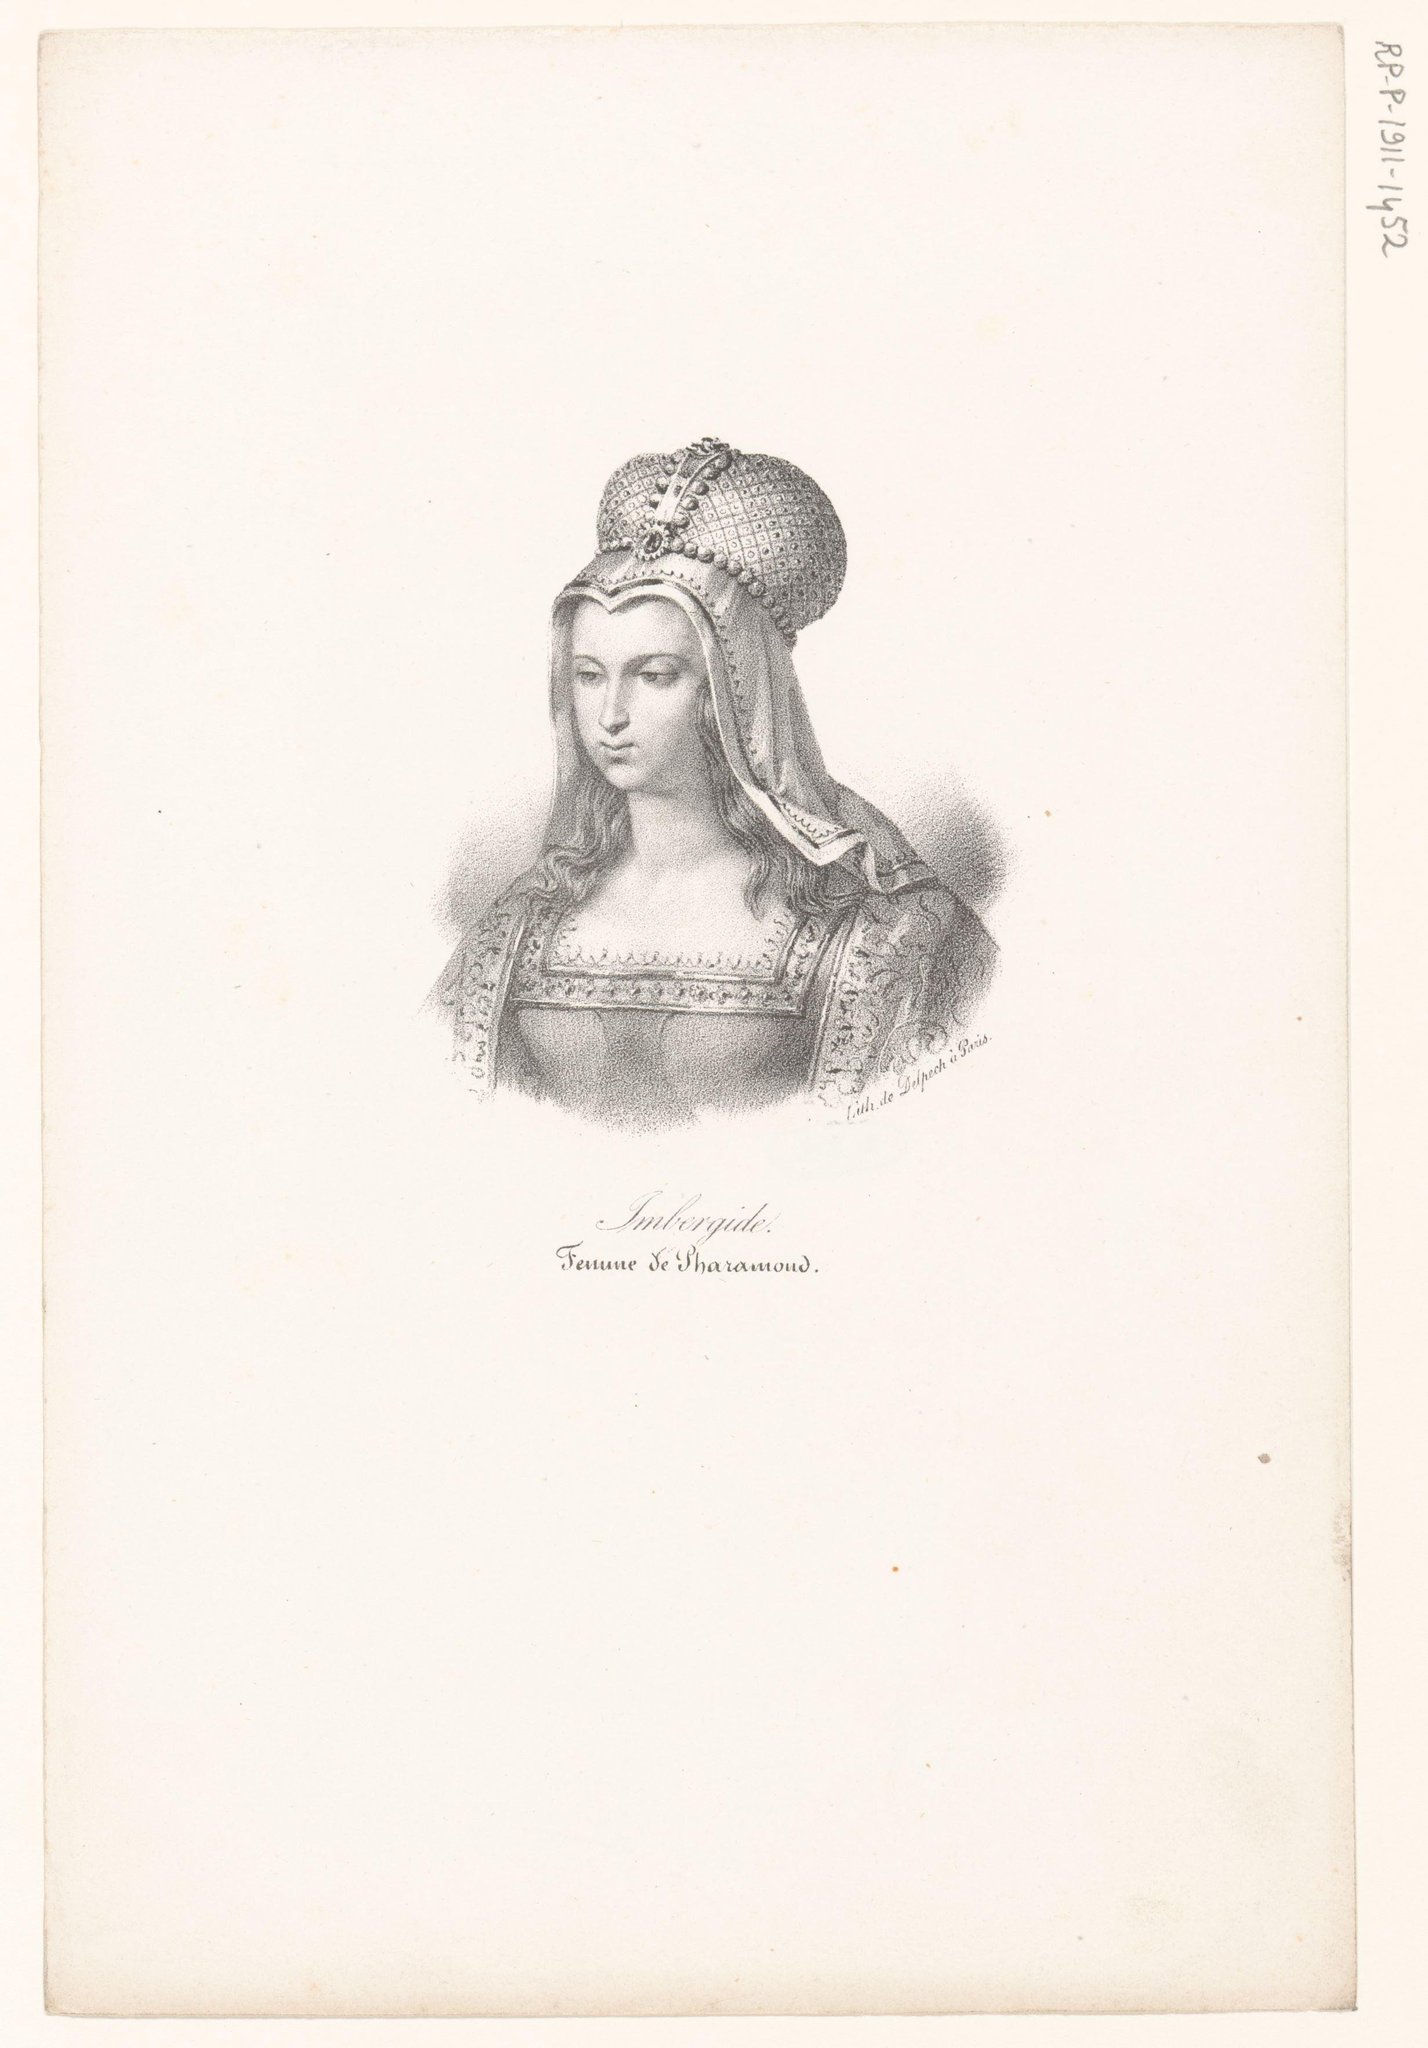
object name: print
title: Portret van koningin Embegirde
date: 1818-1842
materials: paper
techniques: lithograph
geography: paris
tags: historical persons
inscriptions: collector's mark: Lugt 2228a